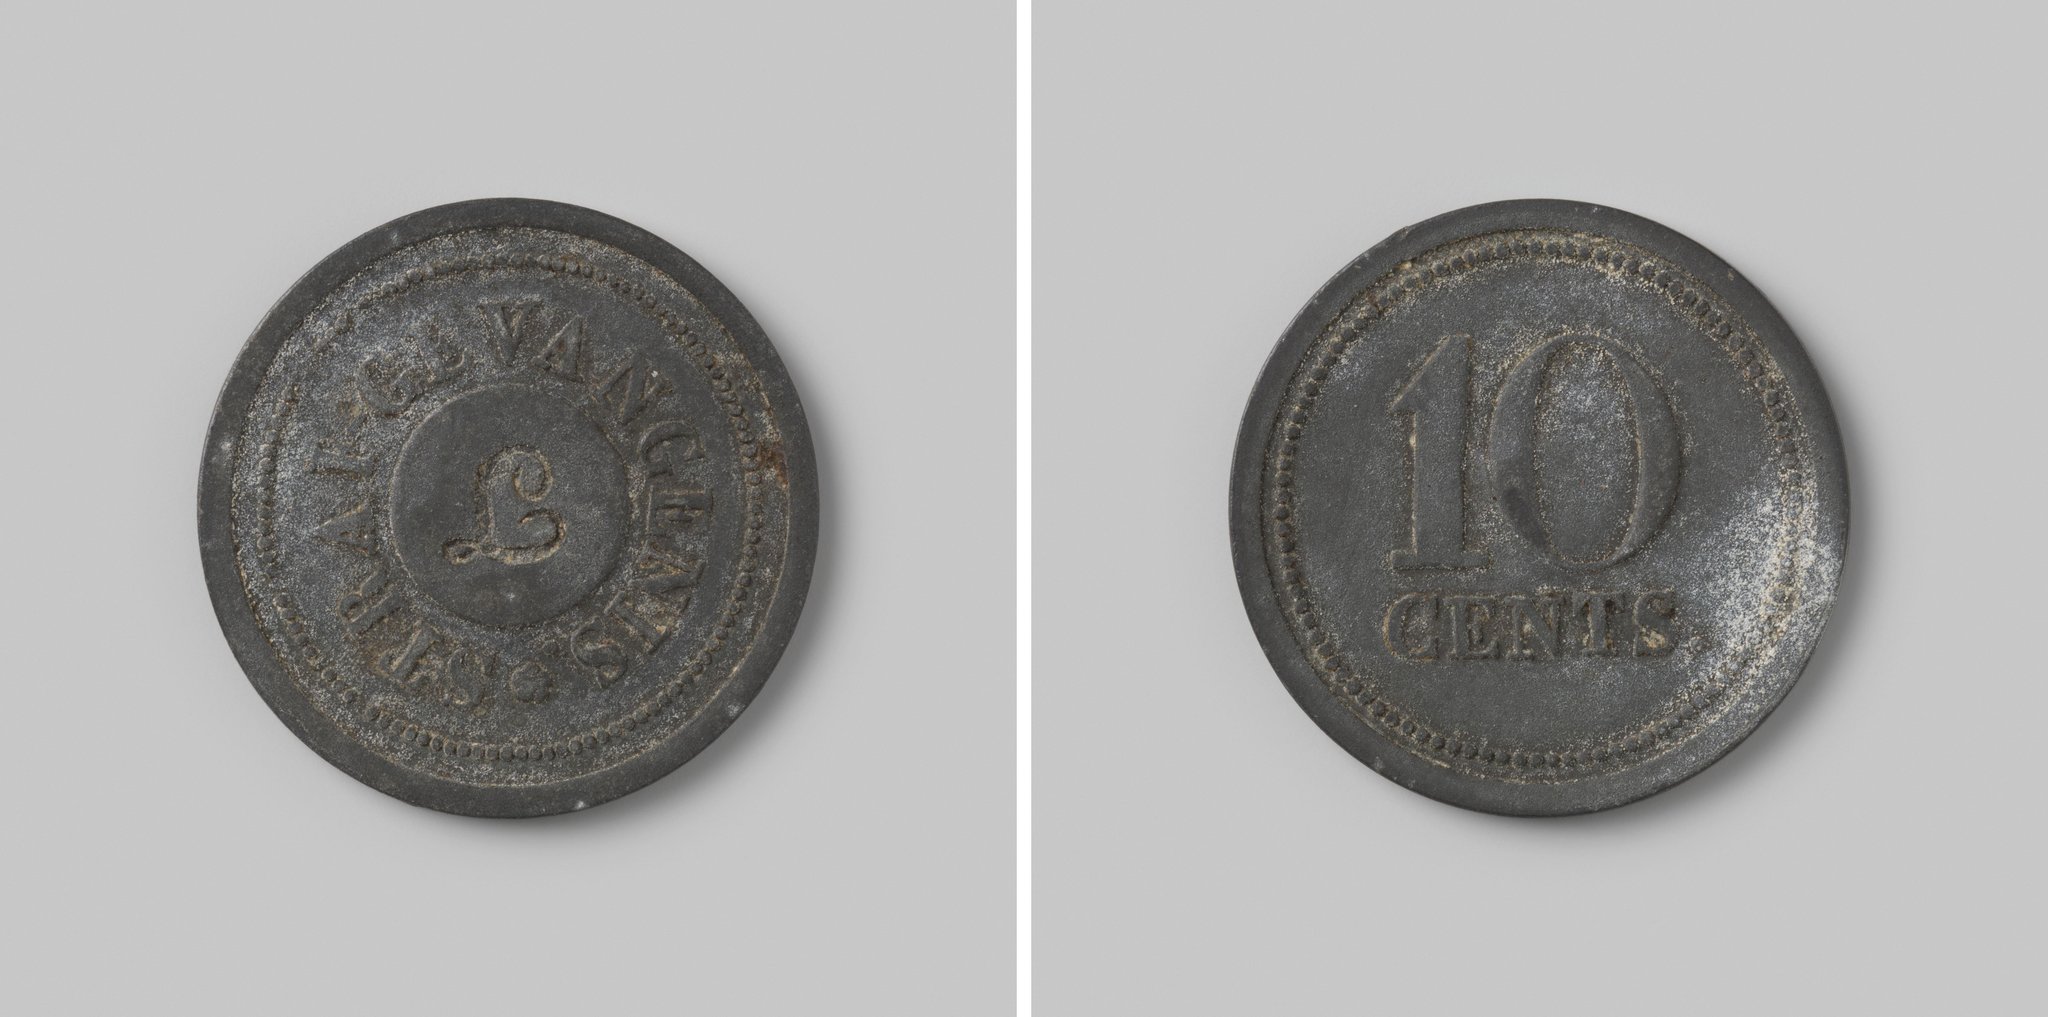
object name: tien cent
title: Betaalpenning voor Nederlandse strafgevangenissen, tien cents gemerkt L (Leeuwarden)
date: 1834-1861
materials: zinc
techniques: striking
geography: utrecht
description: Zinken betaalpenning, op de voorzijde een verhoogd middenveld met instempeling L, met omschrift, op de keerzijde de waarde in twee regels.